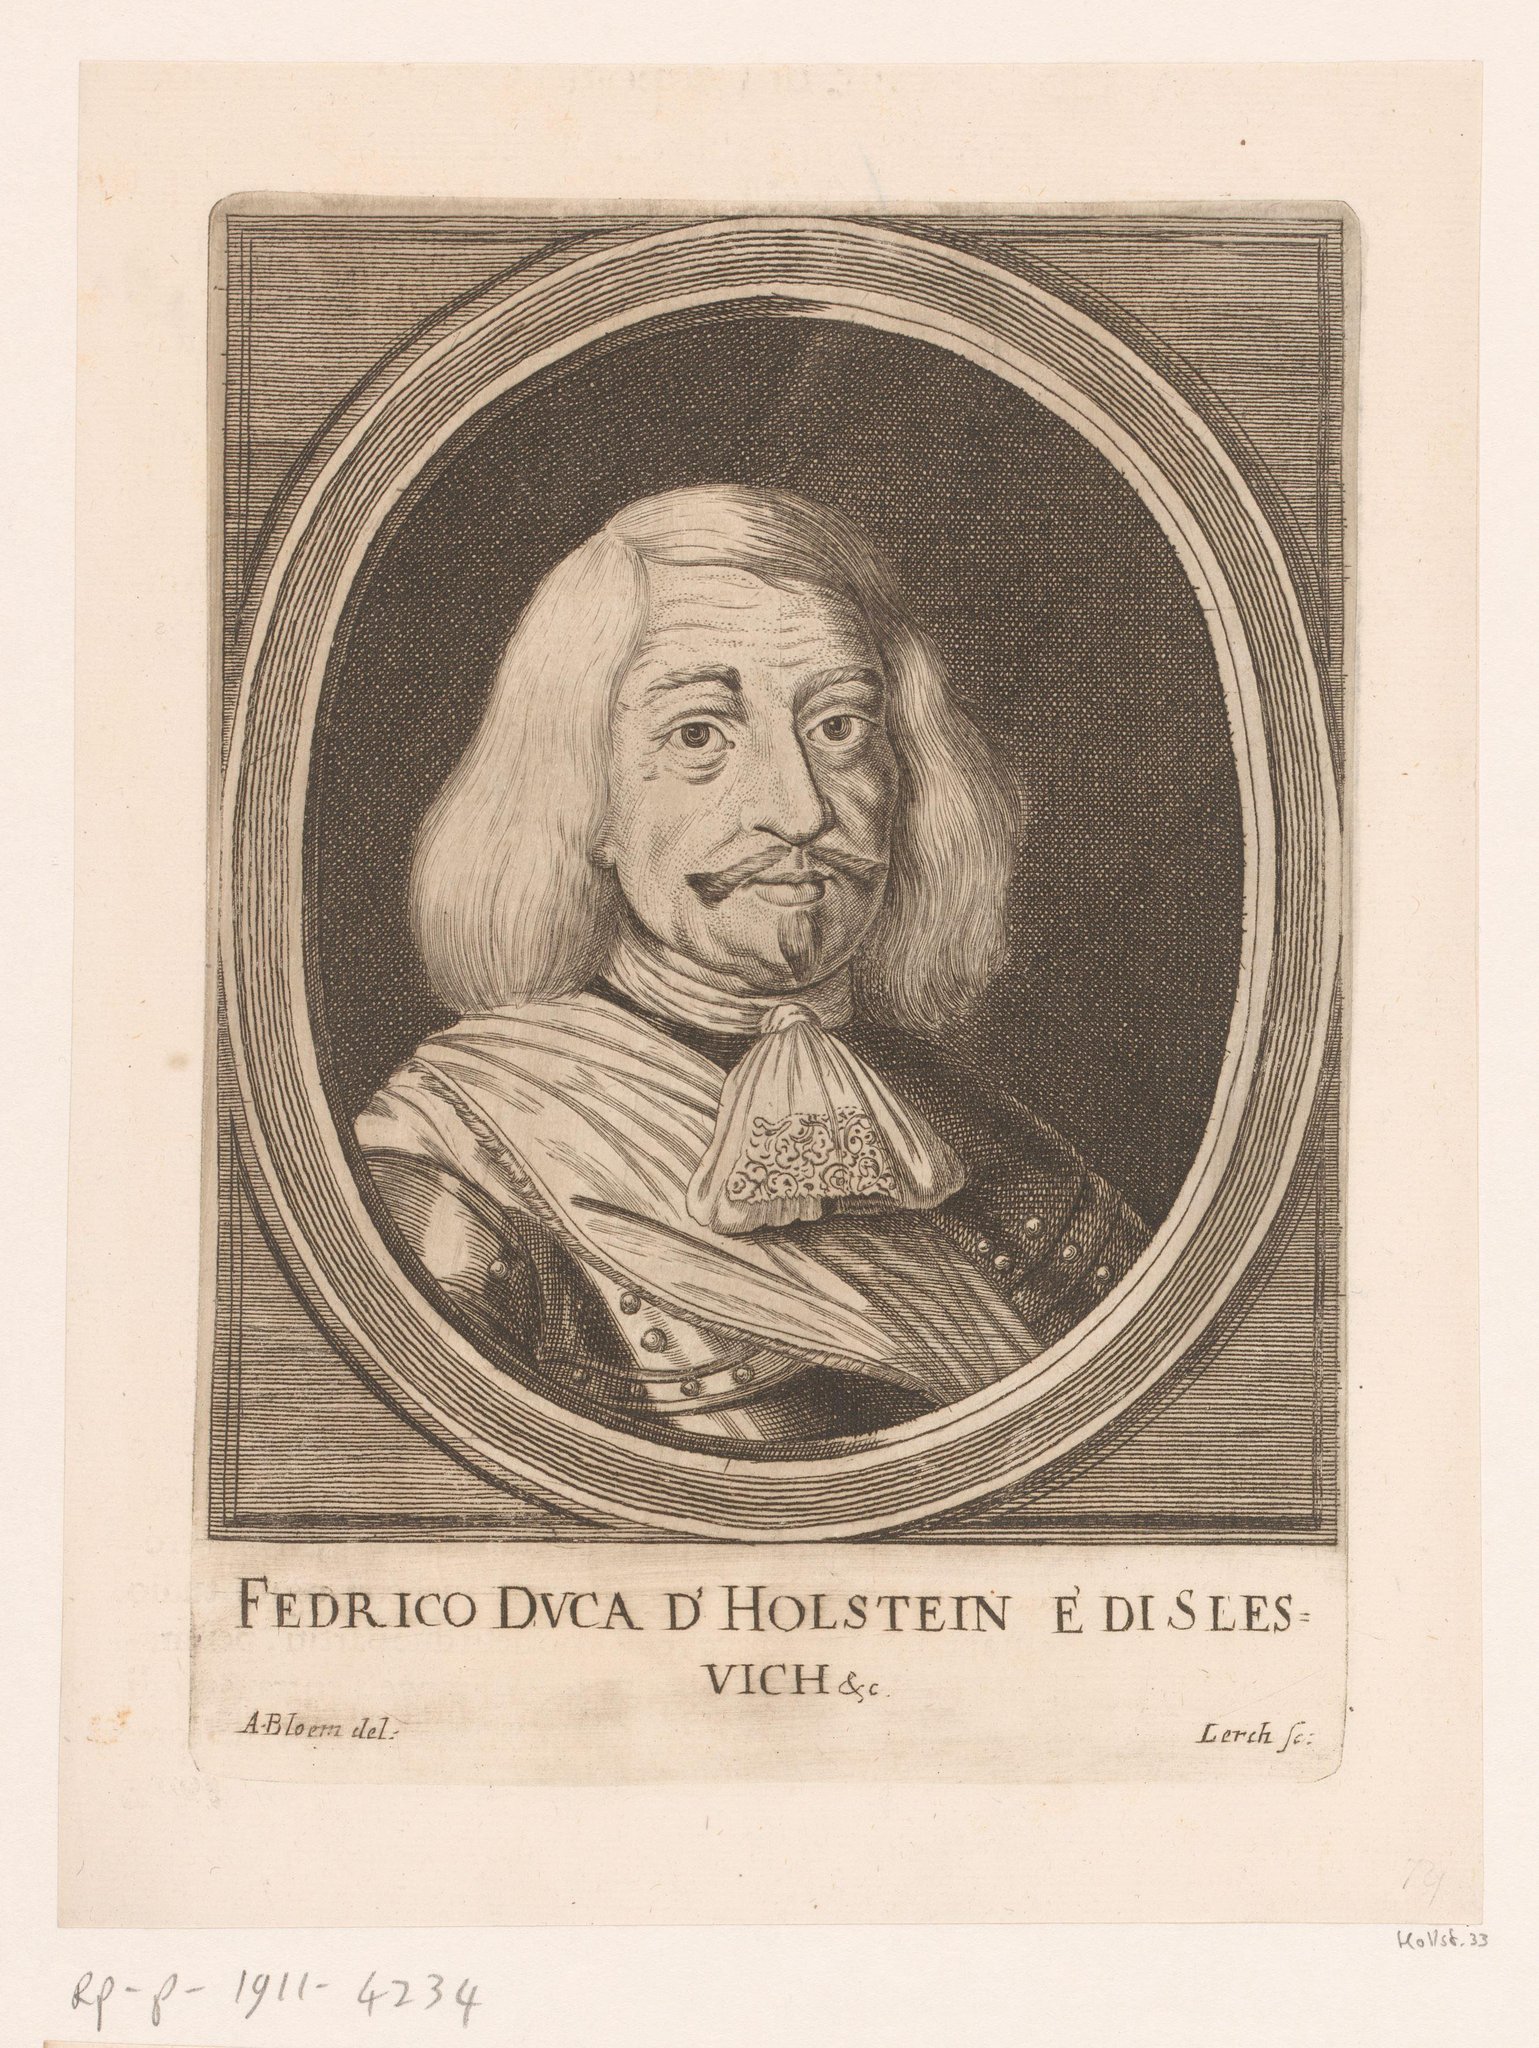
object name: print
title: Portret van Friedrich Ludwig von Schleswig-Holstein-Beck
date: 1660-1685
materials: paper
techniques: engraving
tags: historical persons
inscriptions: collector's mark: Lugt 2228